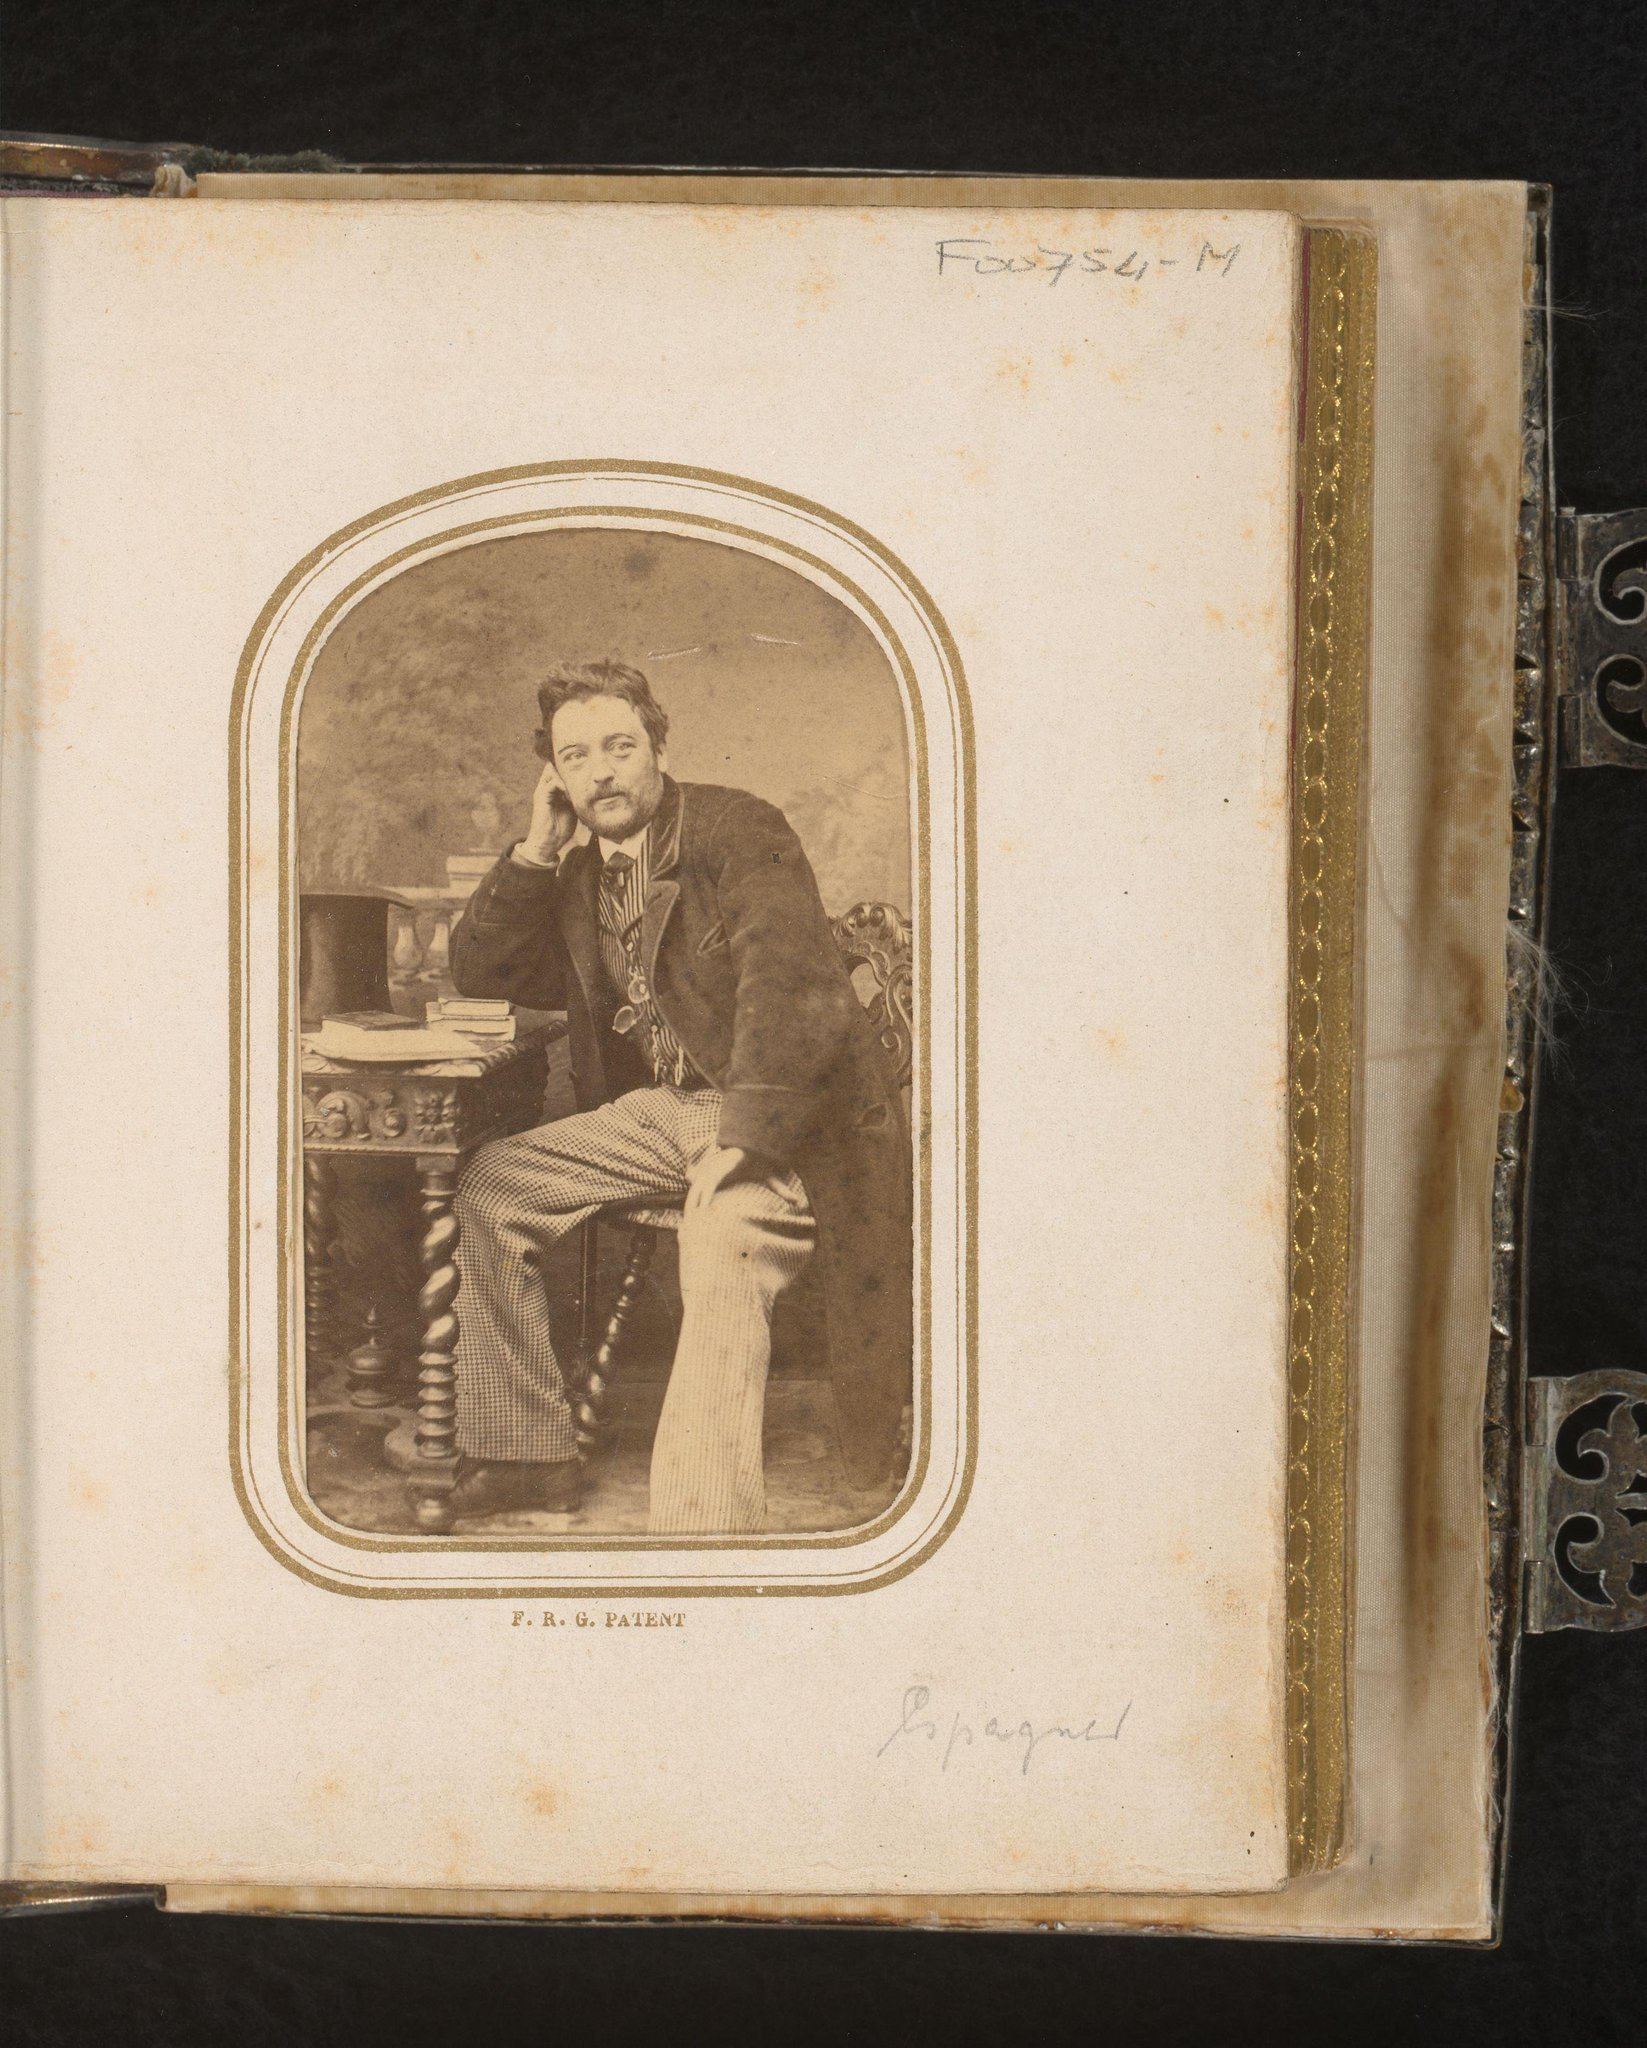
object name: album leaf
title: Portret van een zittende man bij een tafel met boeken en hoed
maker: jules espagnet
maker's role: fotograaf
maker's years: 1819-1877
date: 1855-1880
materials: cardboard, photographic support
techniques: albumen print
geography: rouen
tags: historical persons, head-gear: hat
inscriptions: inscription: ‘Rouen, Place Imperiale 6’